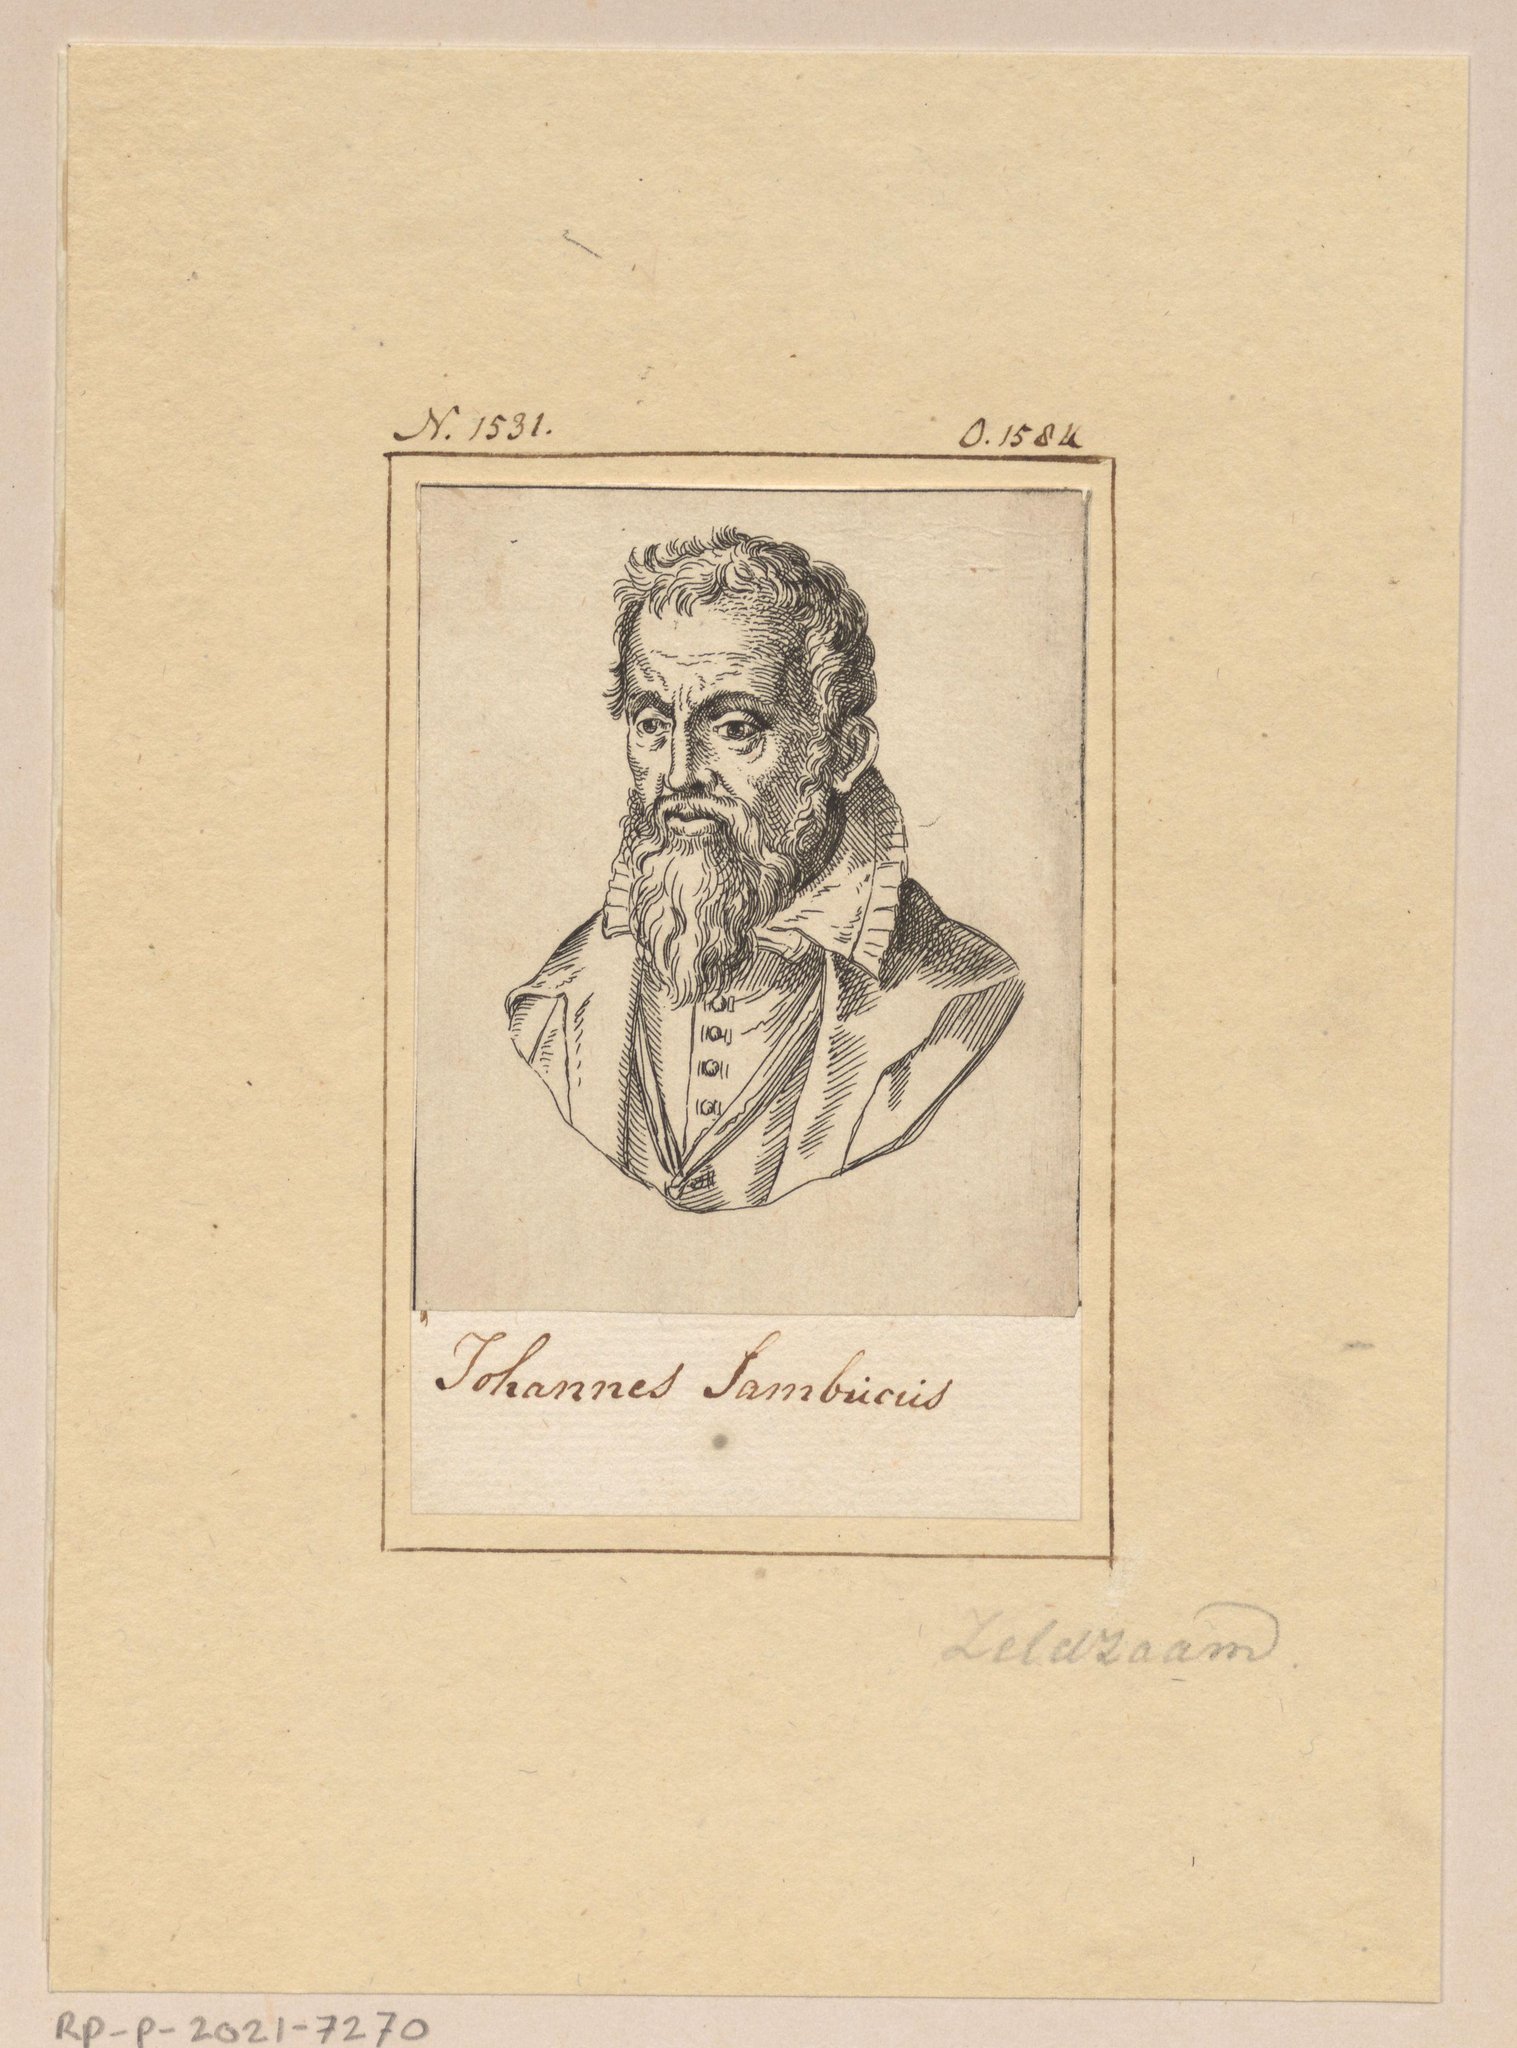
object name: print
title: Portret van Johannes Sambucus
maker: Anonymous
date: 1600-1699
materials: paper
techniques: etching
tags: johannes sambucus, scholar, philosopher, historical persons